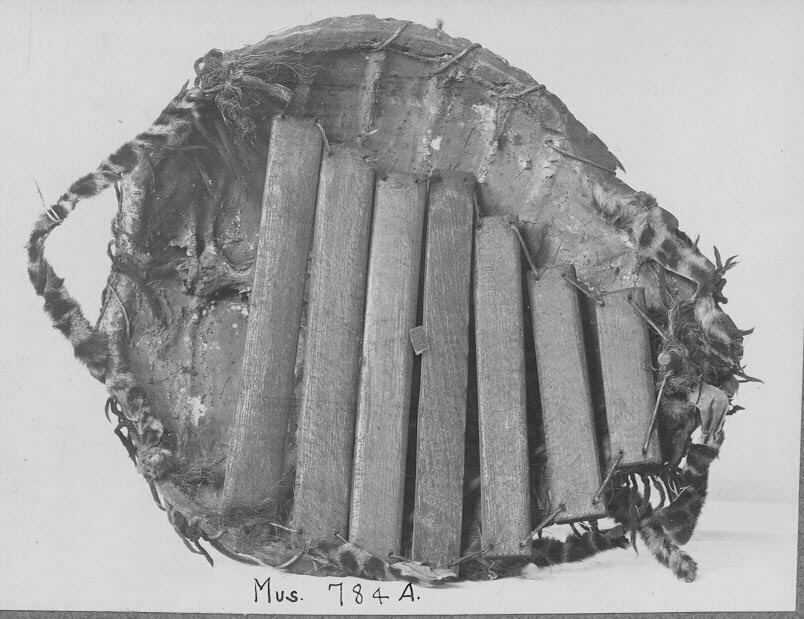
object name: xylophone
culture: african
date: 1801-1900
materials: hemp, shell, skin, wood